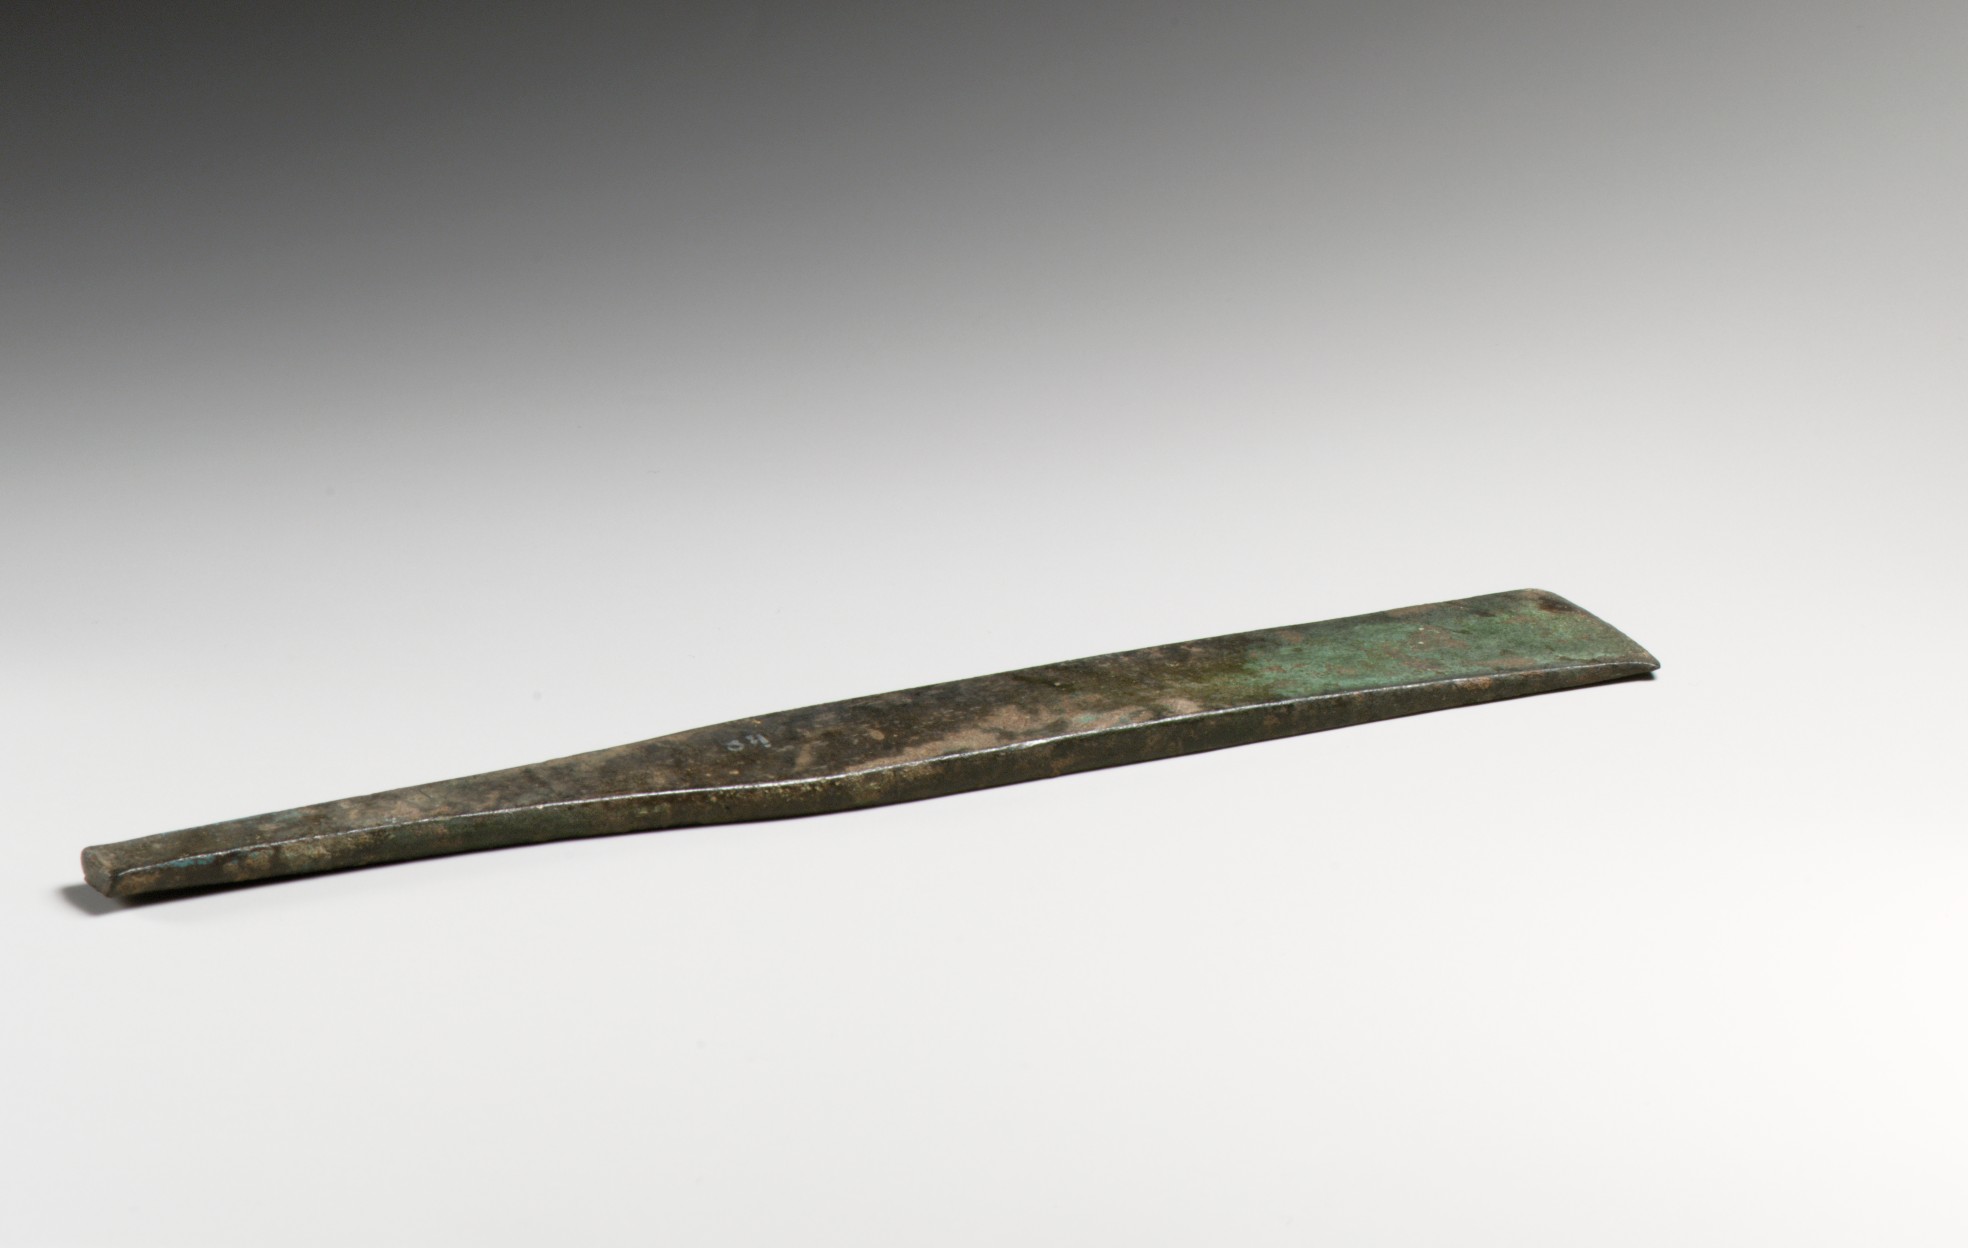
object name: chisel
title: Bronze chisel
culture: minoan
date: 1600-1450 BCE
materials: bronze